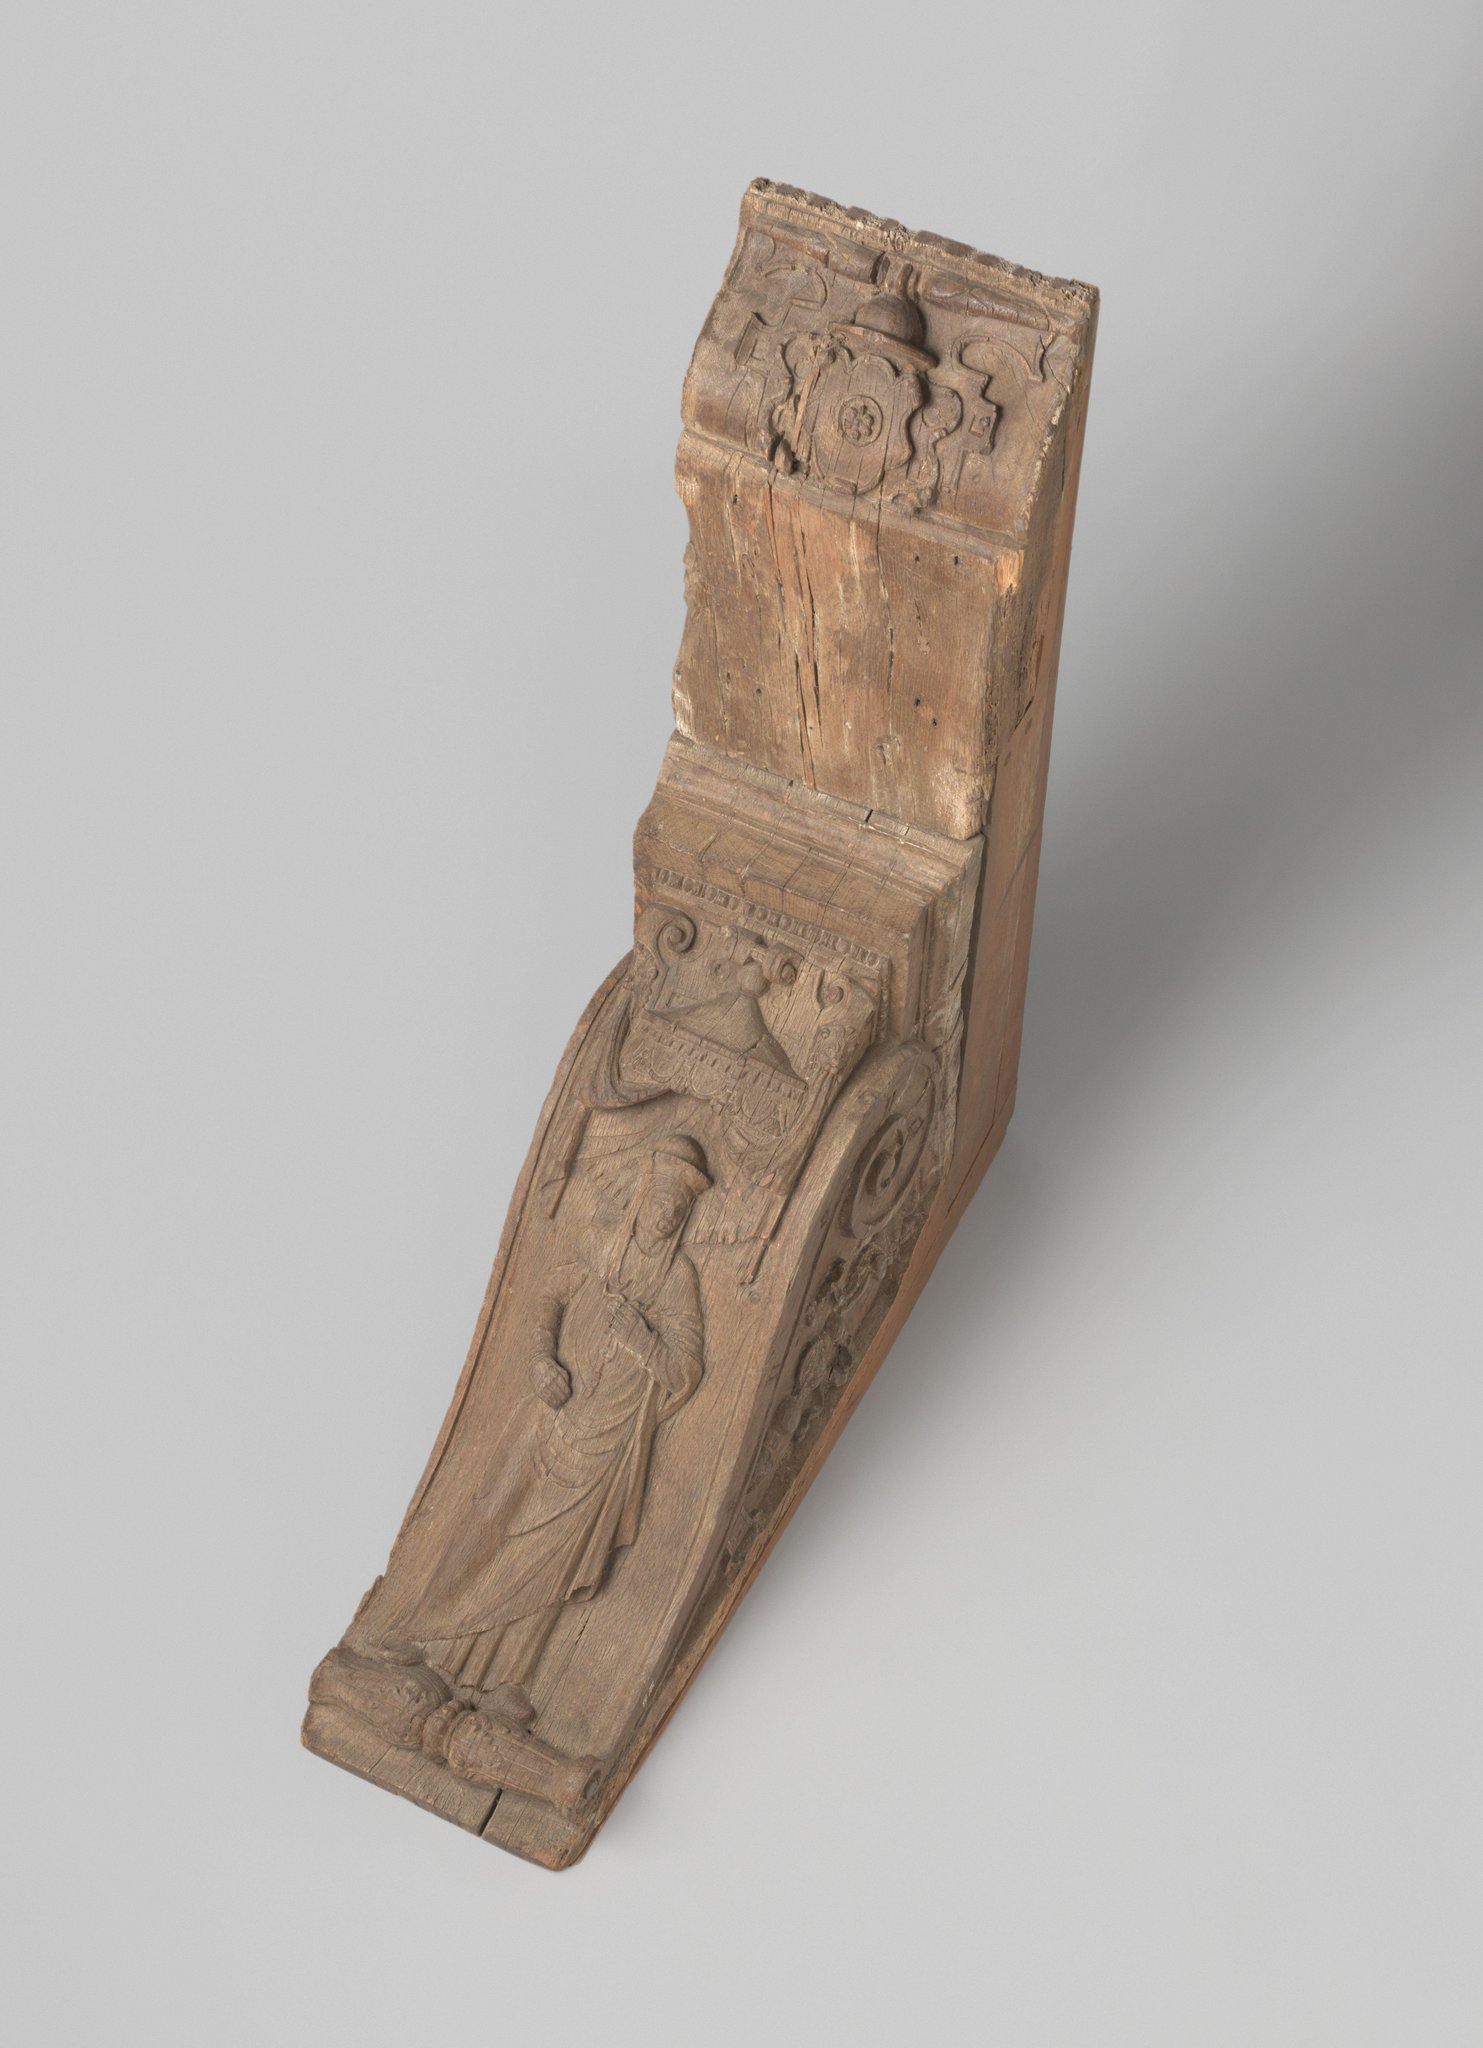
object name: balksleutel, sleutelstuk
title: Korbeel met gesneden voorstelling van een keurvorst-aartsbisschop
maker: Anonymous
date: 1550-1600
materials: wood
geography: northern netherlands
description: Korbeel van eikenhout met een gesneden voorstelling van een keurvorst-aartsbisschop, staande onder een baldakijn. Afkomstig uit het afgebroken huis Warmoesstraat 145 te Amsterdam.